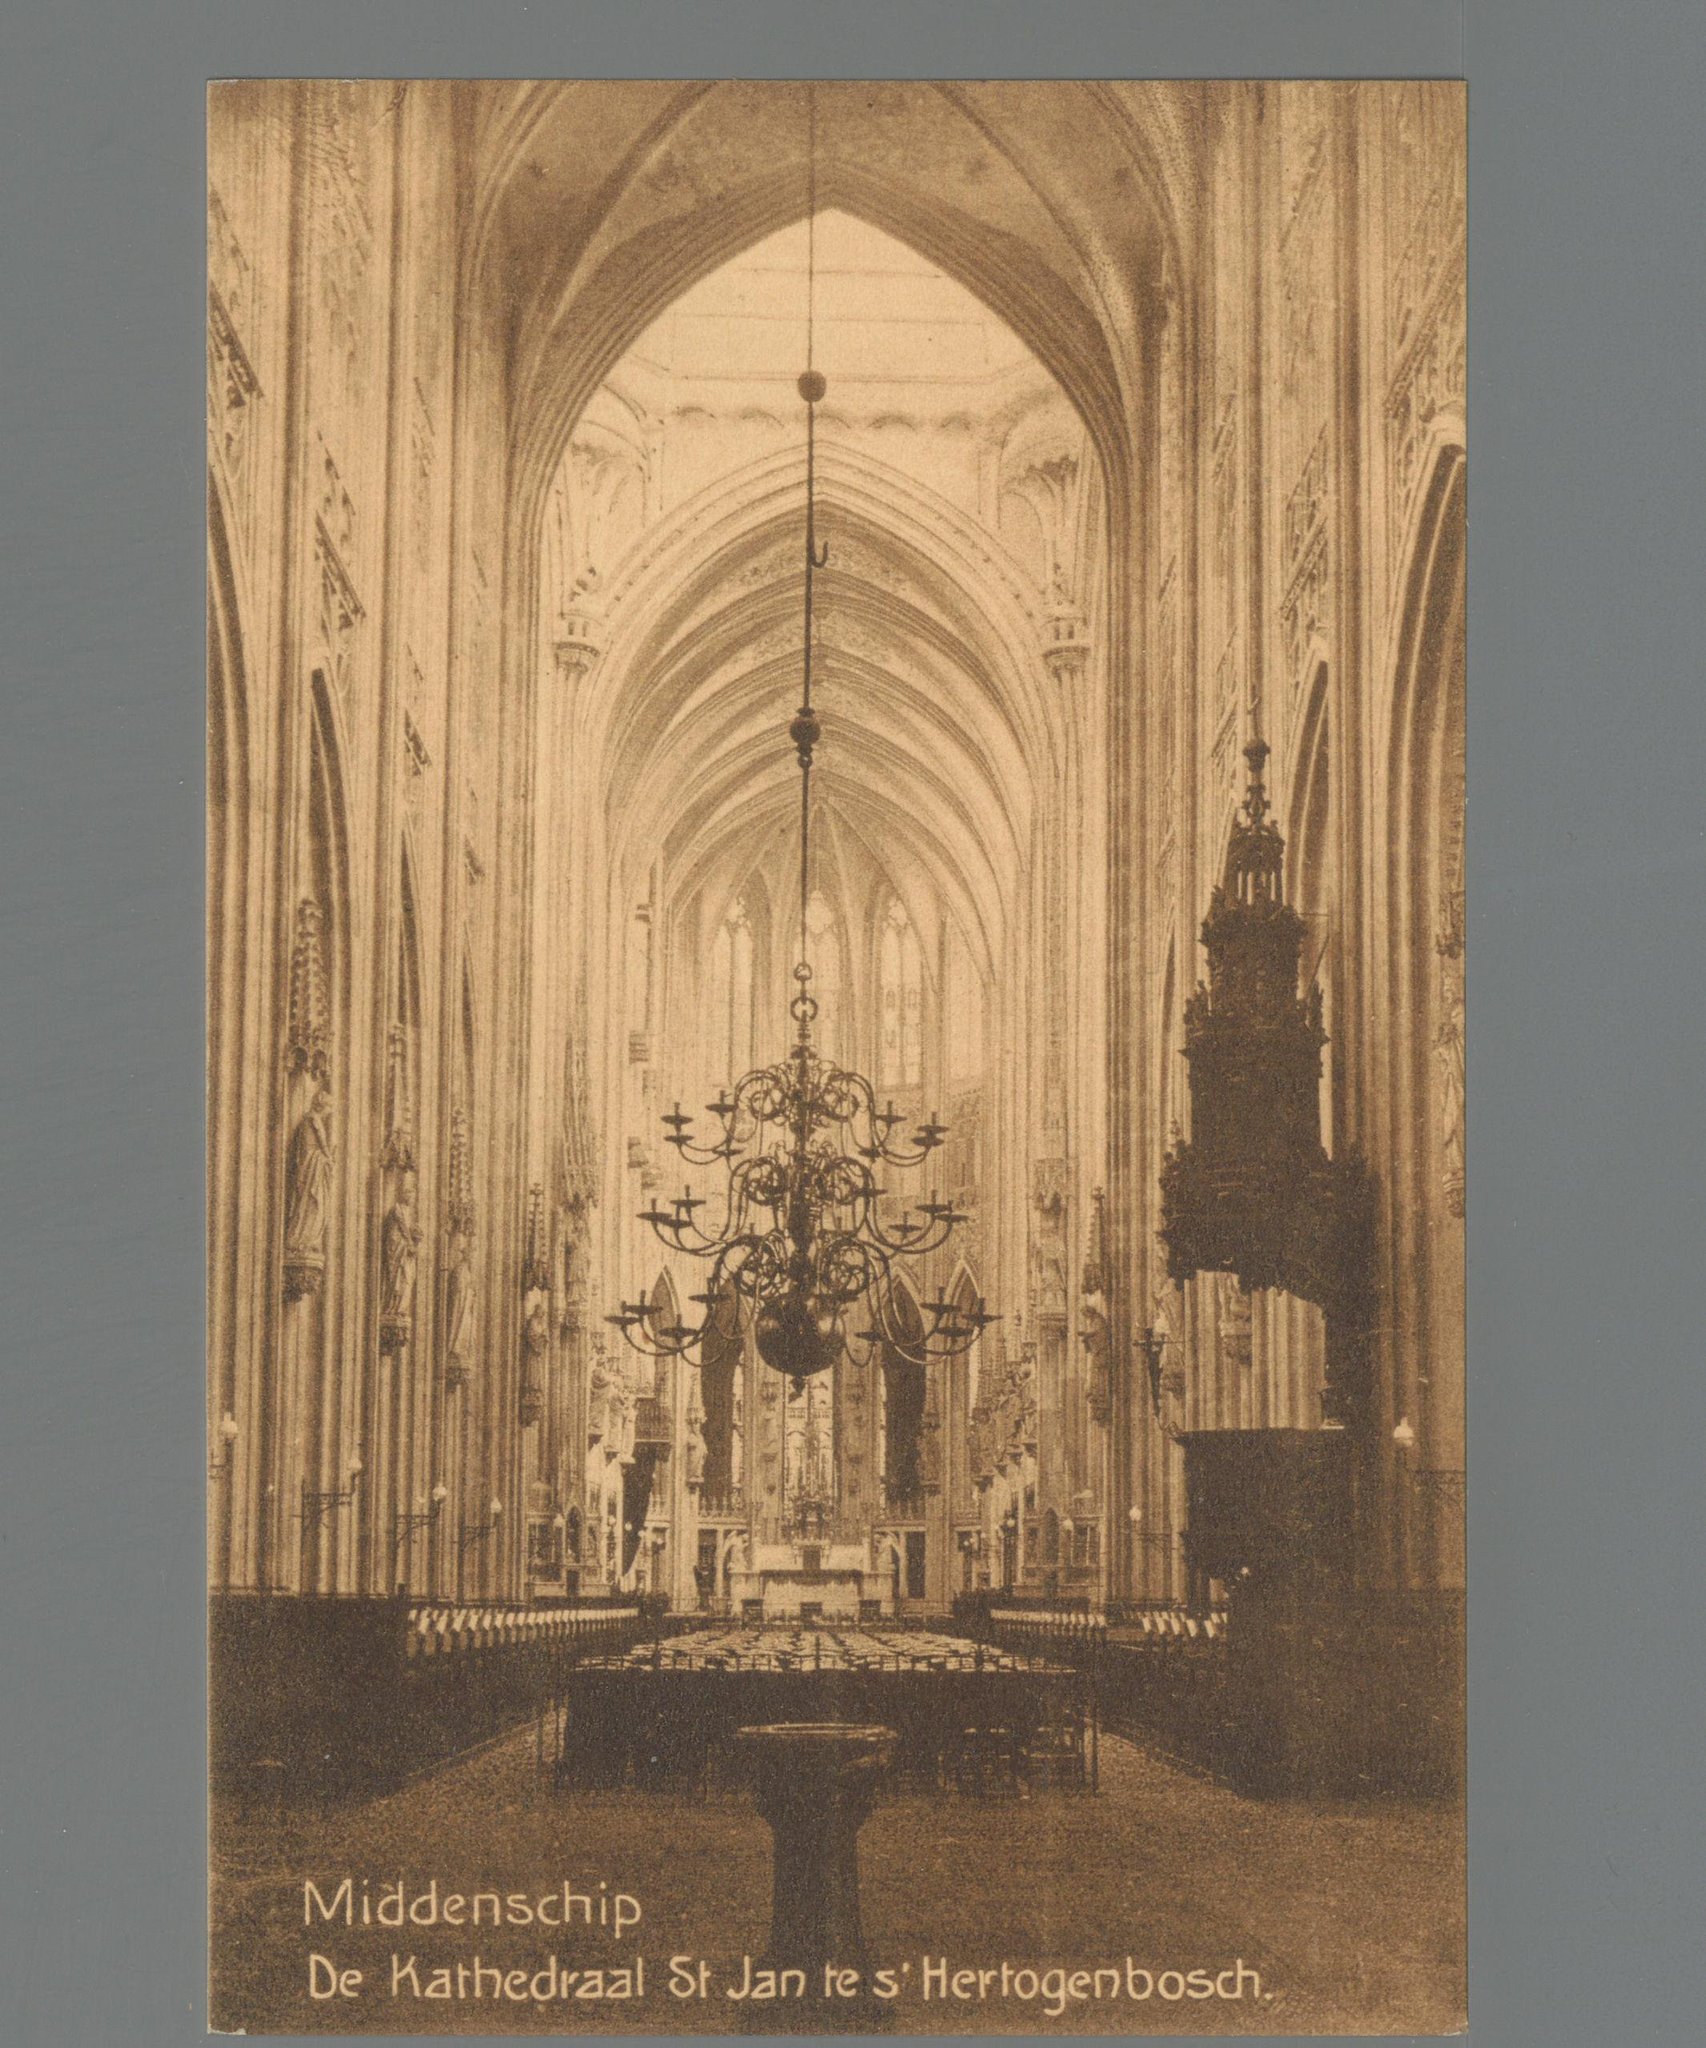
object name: ansichtkaart, prentbriefkaart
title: Middenschip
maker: Anonymous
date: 1905-1930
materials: cardboard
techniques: photograph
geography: den bosch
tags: parts of church interior: nave